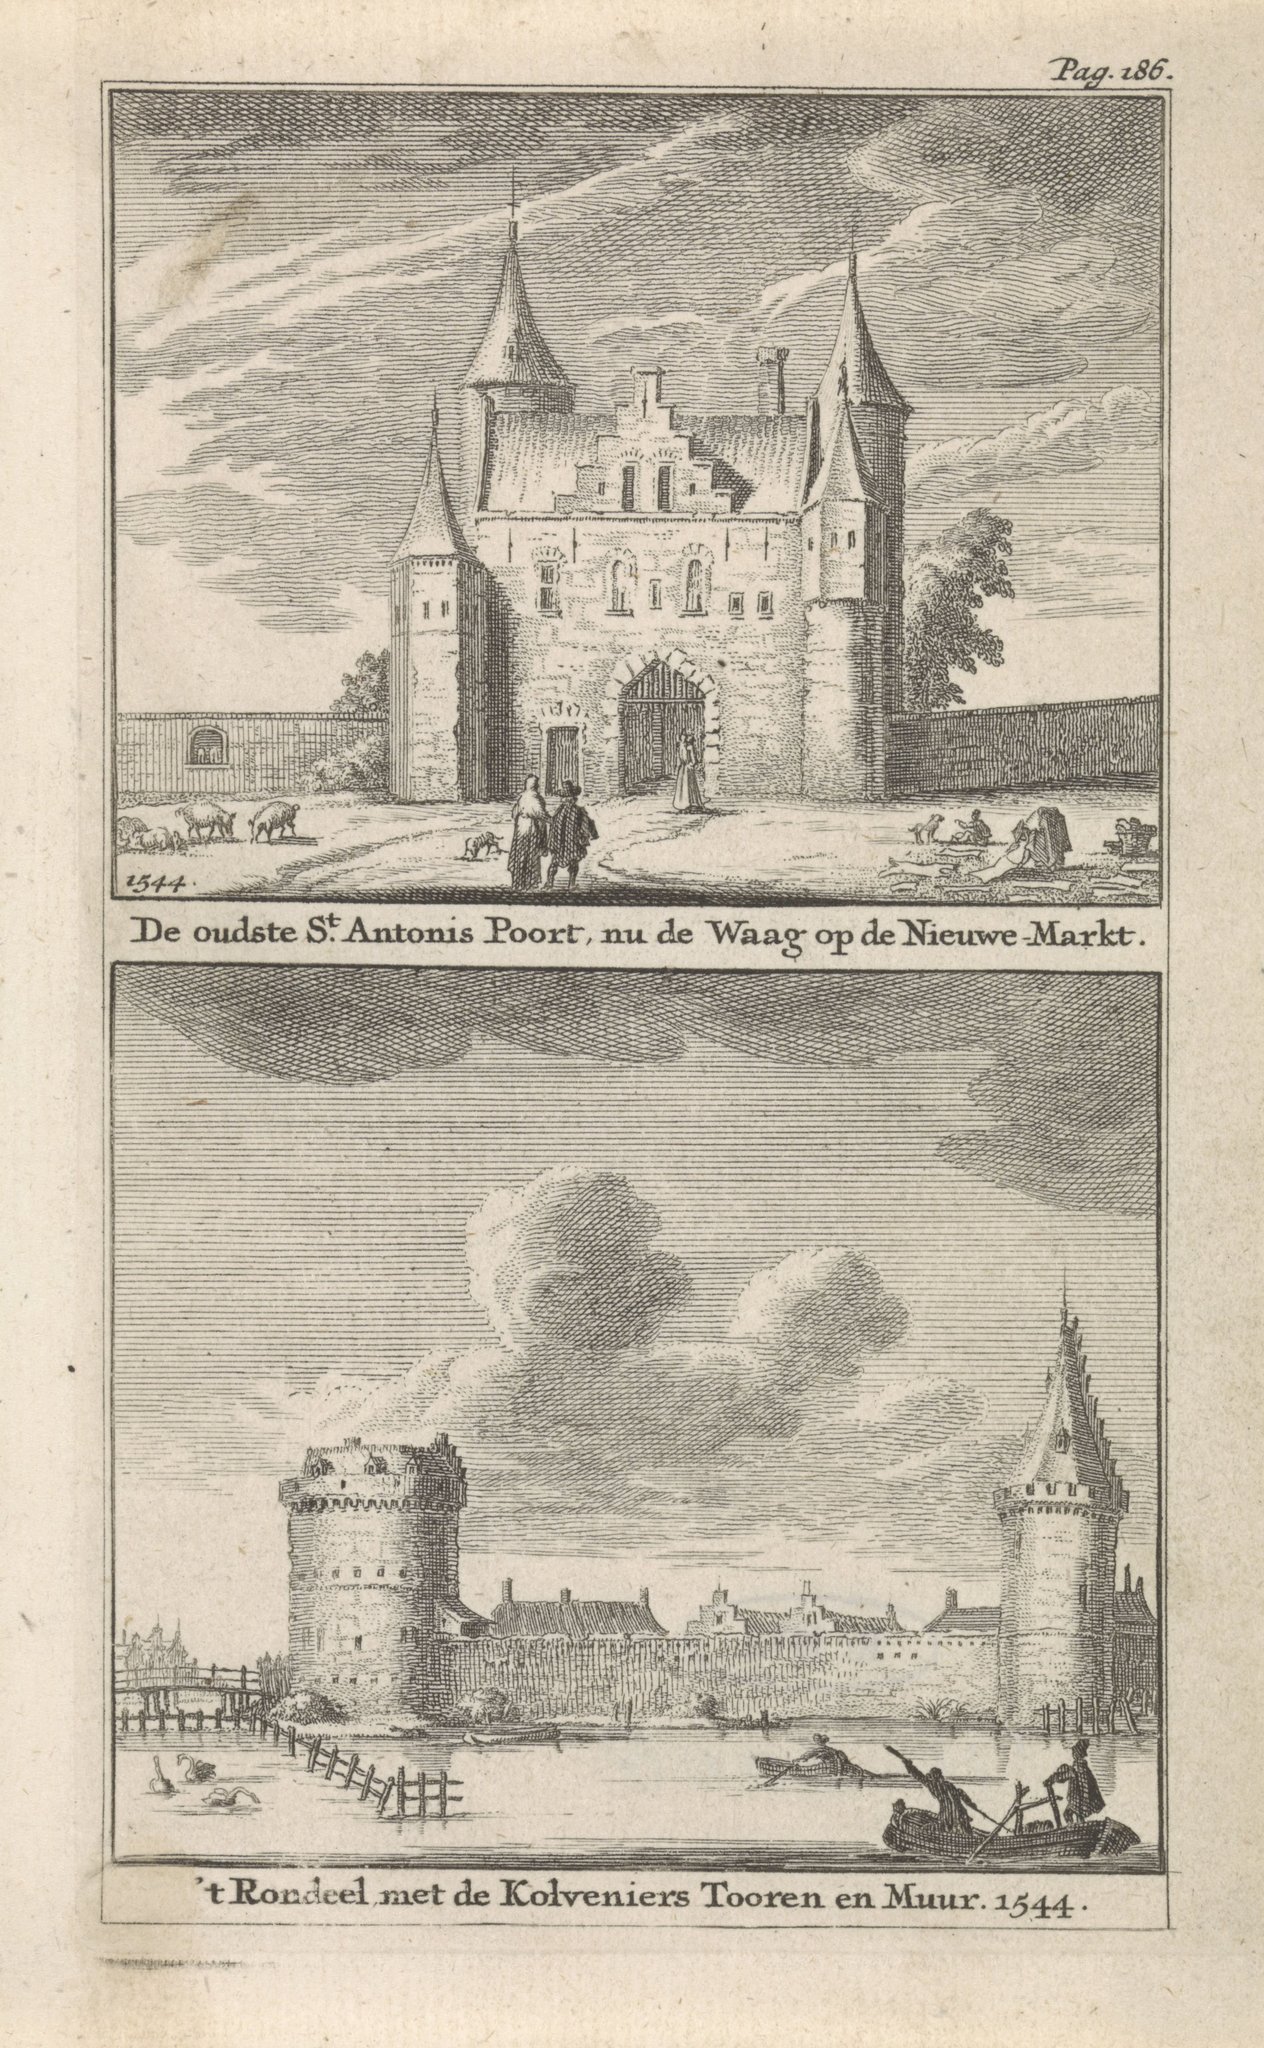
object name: print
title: Gezicht op de Sint-Antoniespoort en het Rondeel te Amsterdam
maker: jan goeree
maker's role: draughtsman, print maker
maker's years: 1670-1731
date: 1723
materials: paper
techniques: engraving, etching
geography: amsterdam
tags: city-gate (+ city(-scape) with figures, staffage)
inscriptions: collector's mark: Lugt 2228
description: Twee voorstellingen. Boven: de Sint-Antoniespoort van Amsterdam. Onder: het Rondeel en de Kolvenierstoren van Amsterdam rond 1544. Elke voorstelling heeft een Nederlands onderschrift. Rechts bovenaan het paginanummer 186.